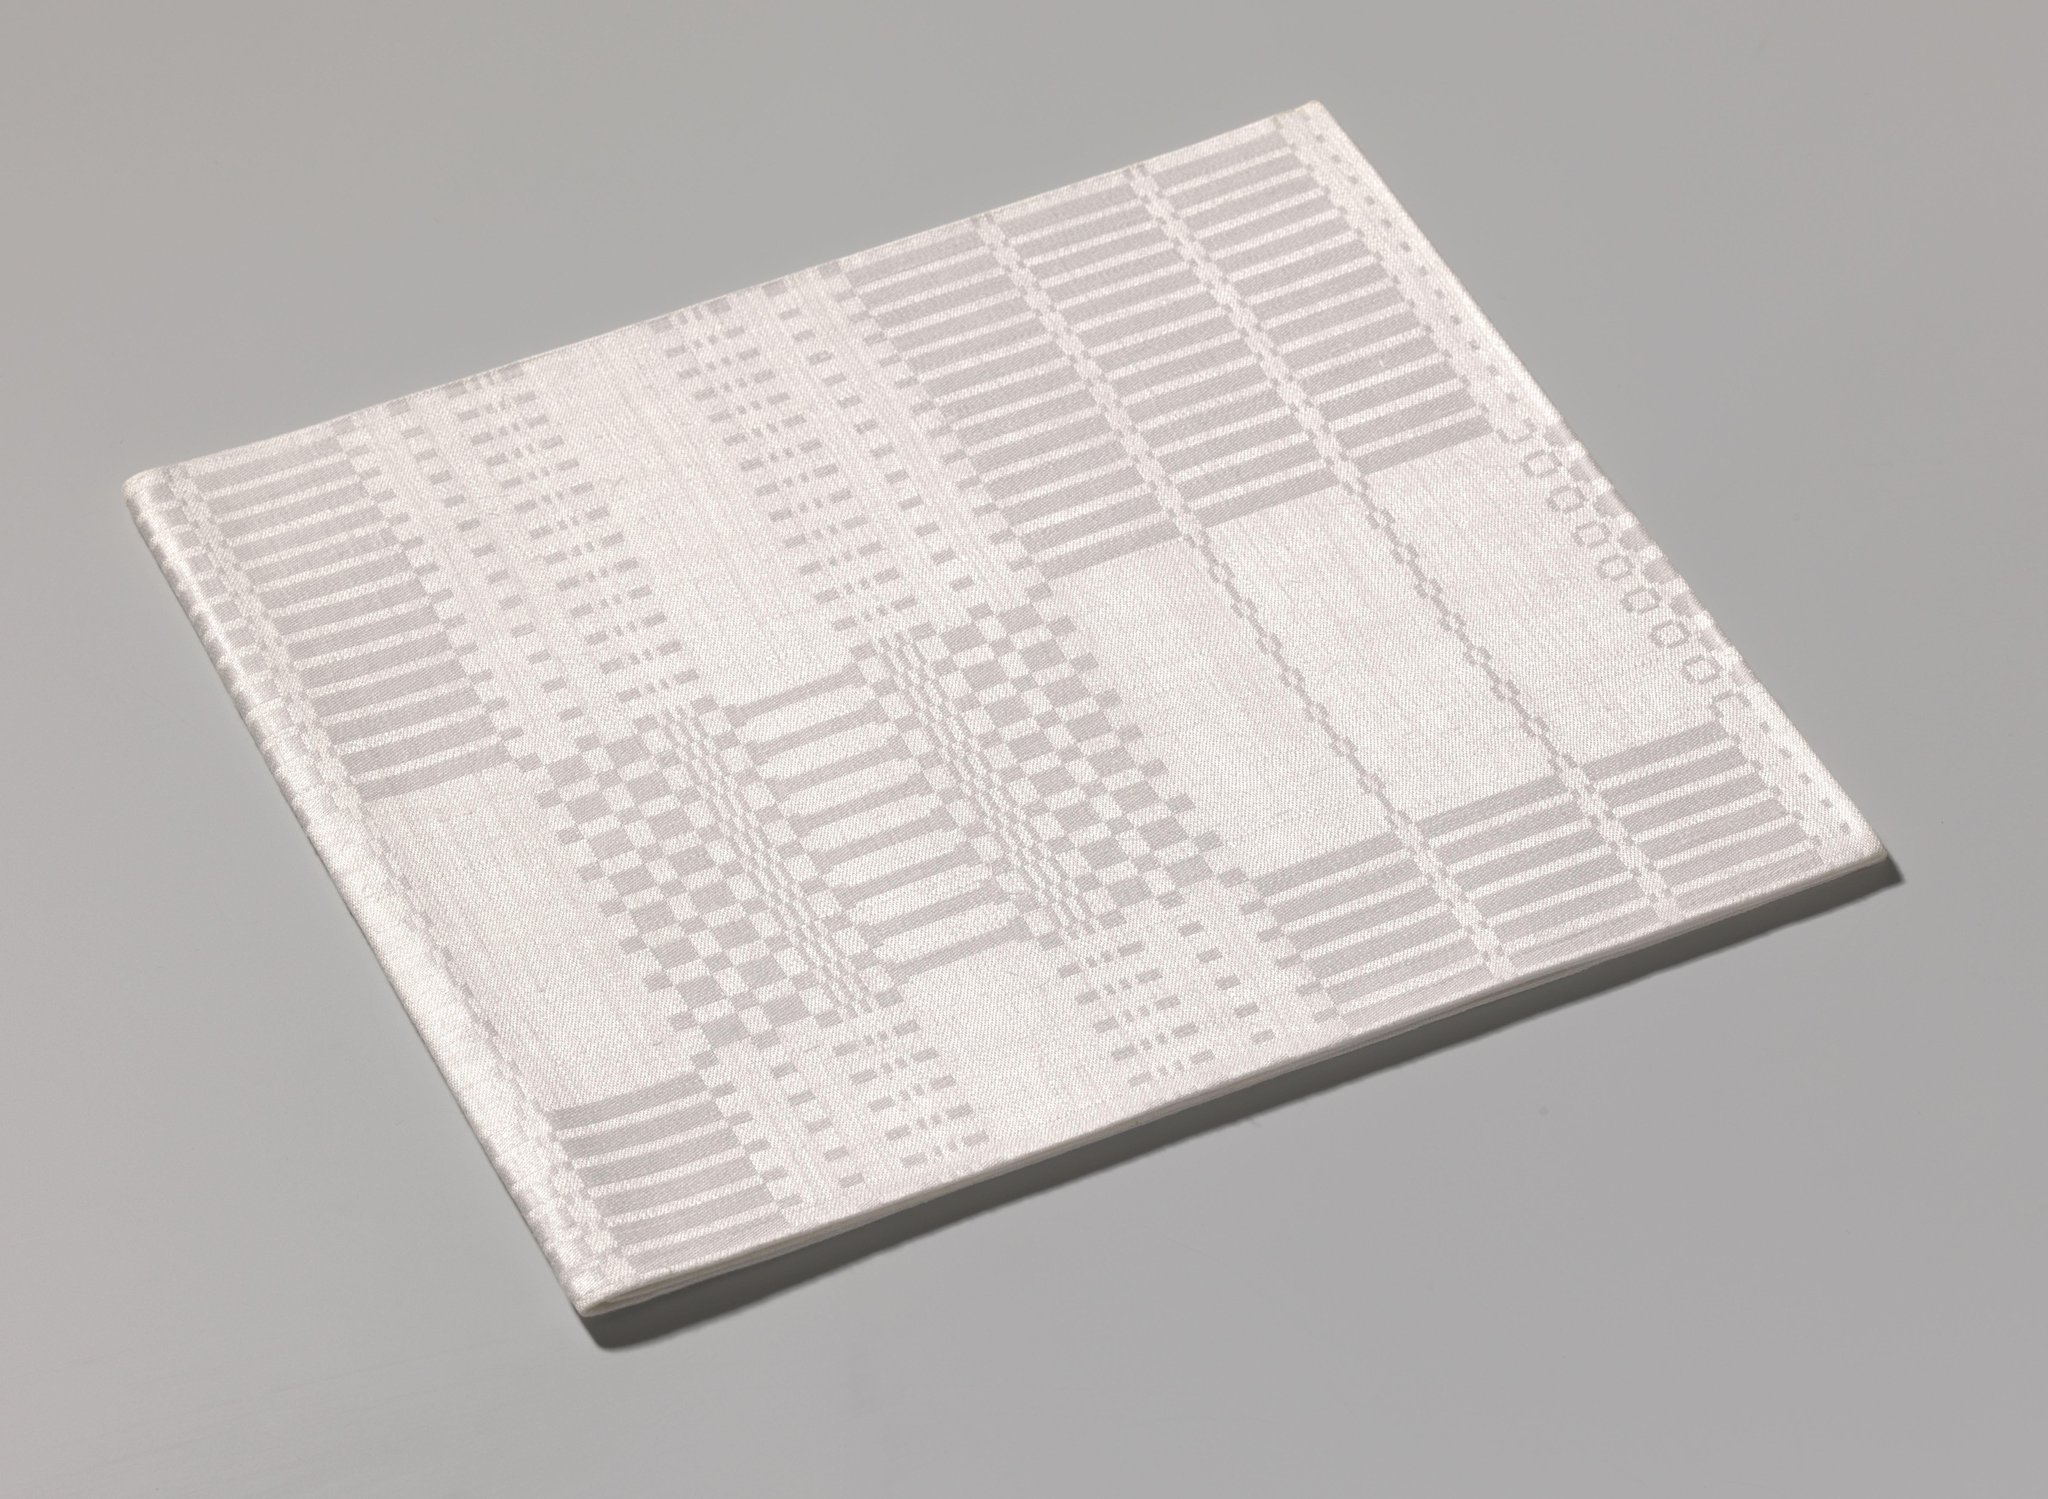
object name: napkin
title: Servet van linnen met pellenpatroon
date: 1790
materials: linen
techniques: peeled fabric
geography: northern netherlands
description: Wit linnendamasten servet met pellenpatroon, merk kroon SW 35 en 1790.